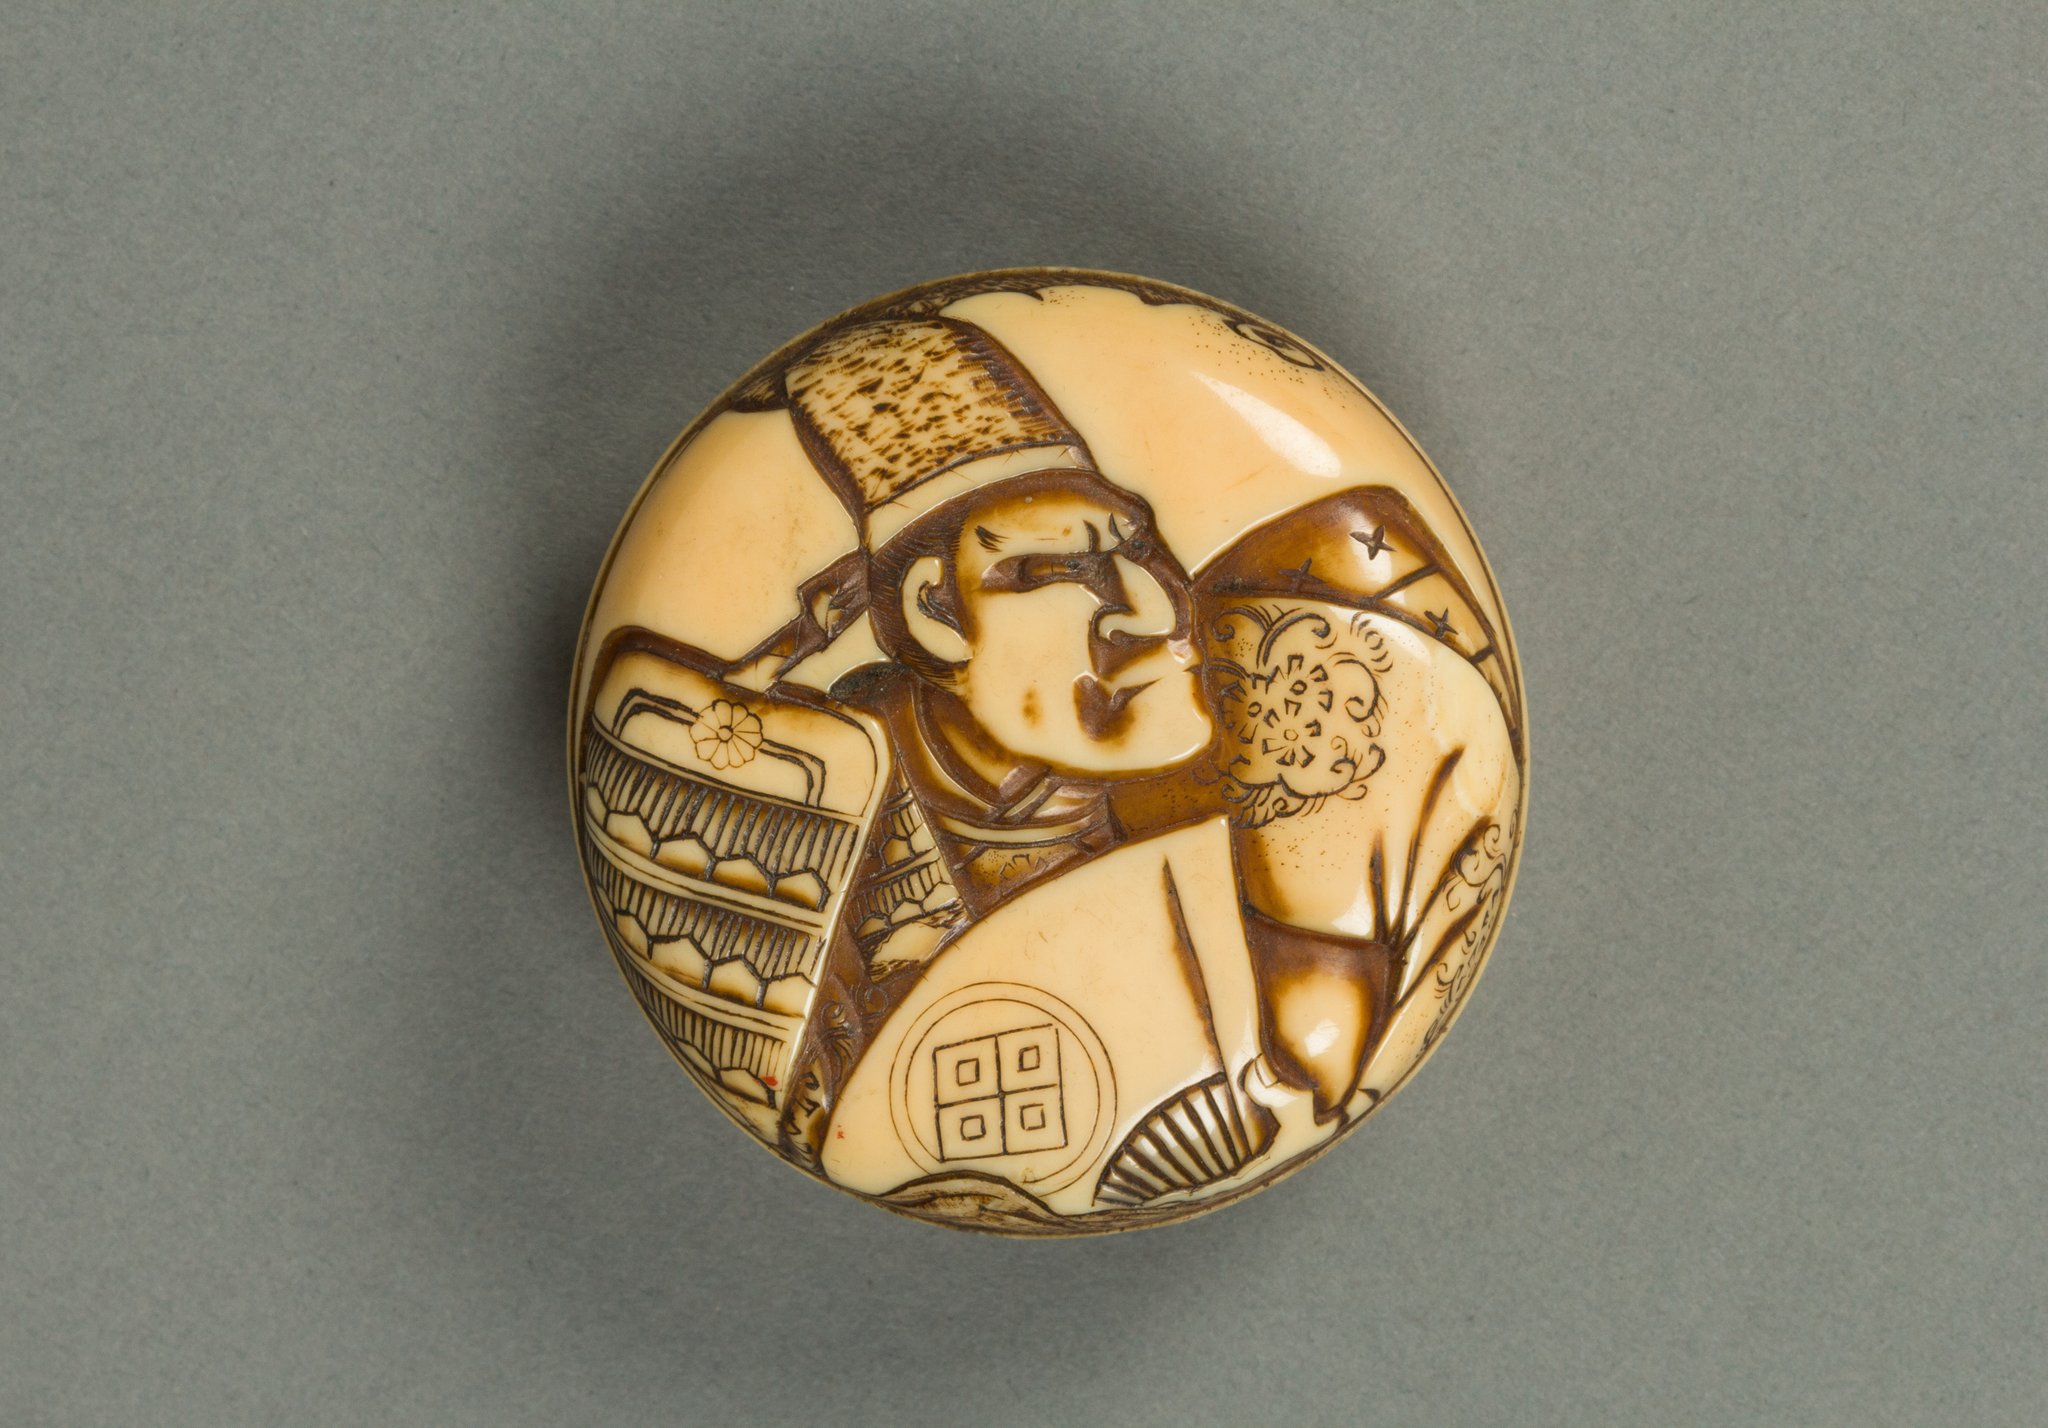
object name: netsuke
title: Netsuke with Carving of an Actor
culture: japanese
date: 1801-1900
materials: ivory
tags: actors